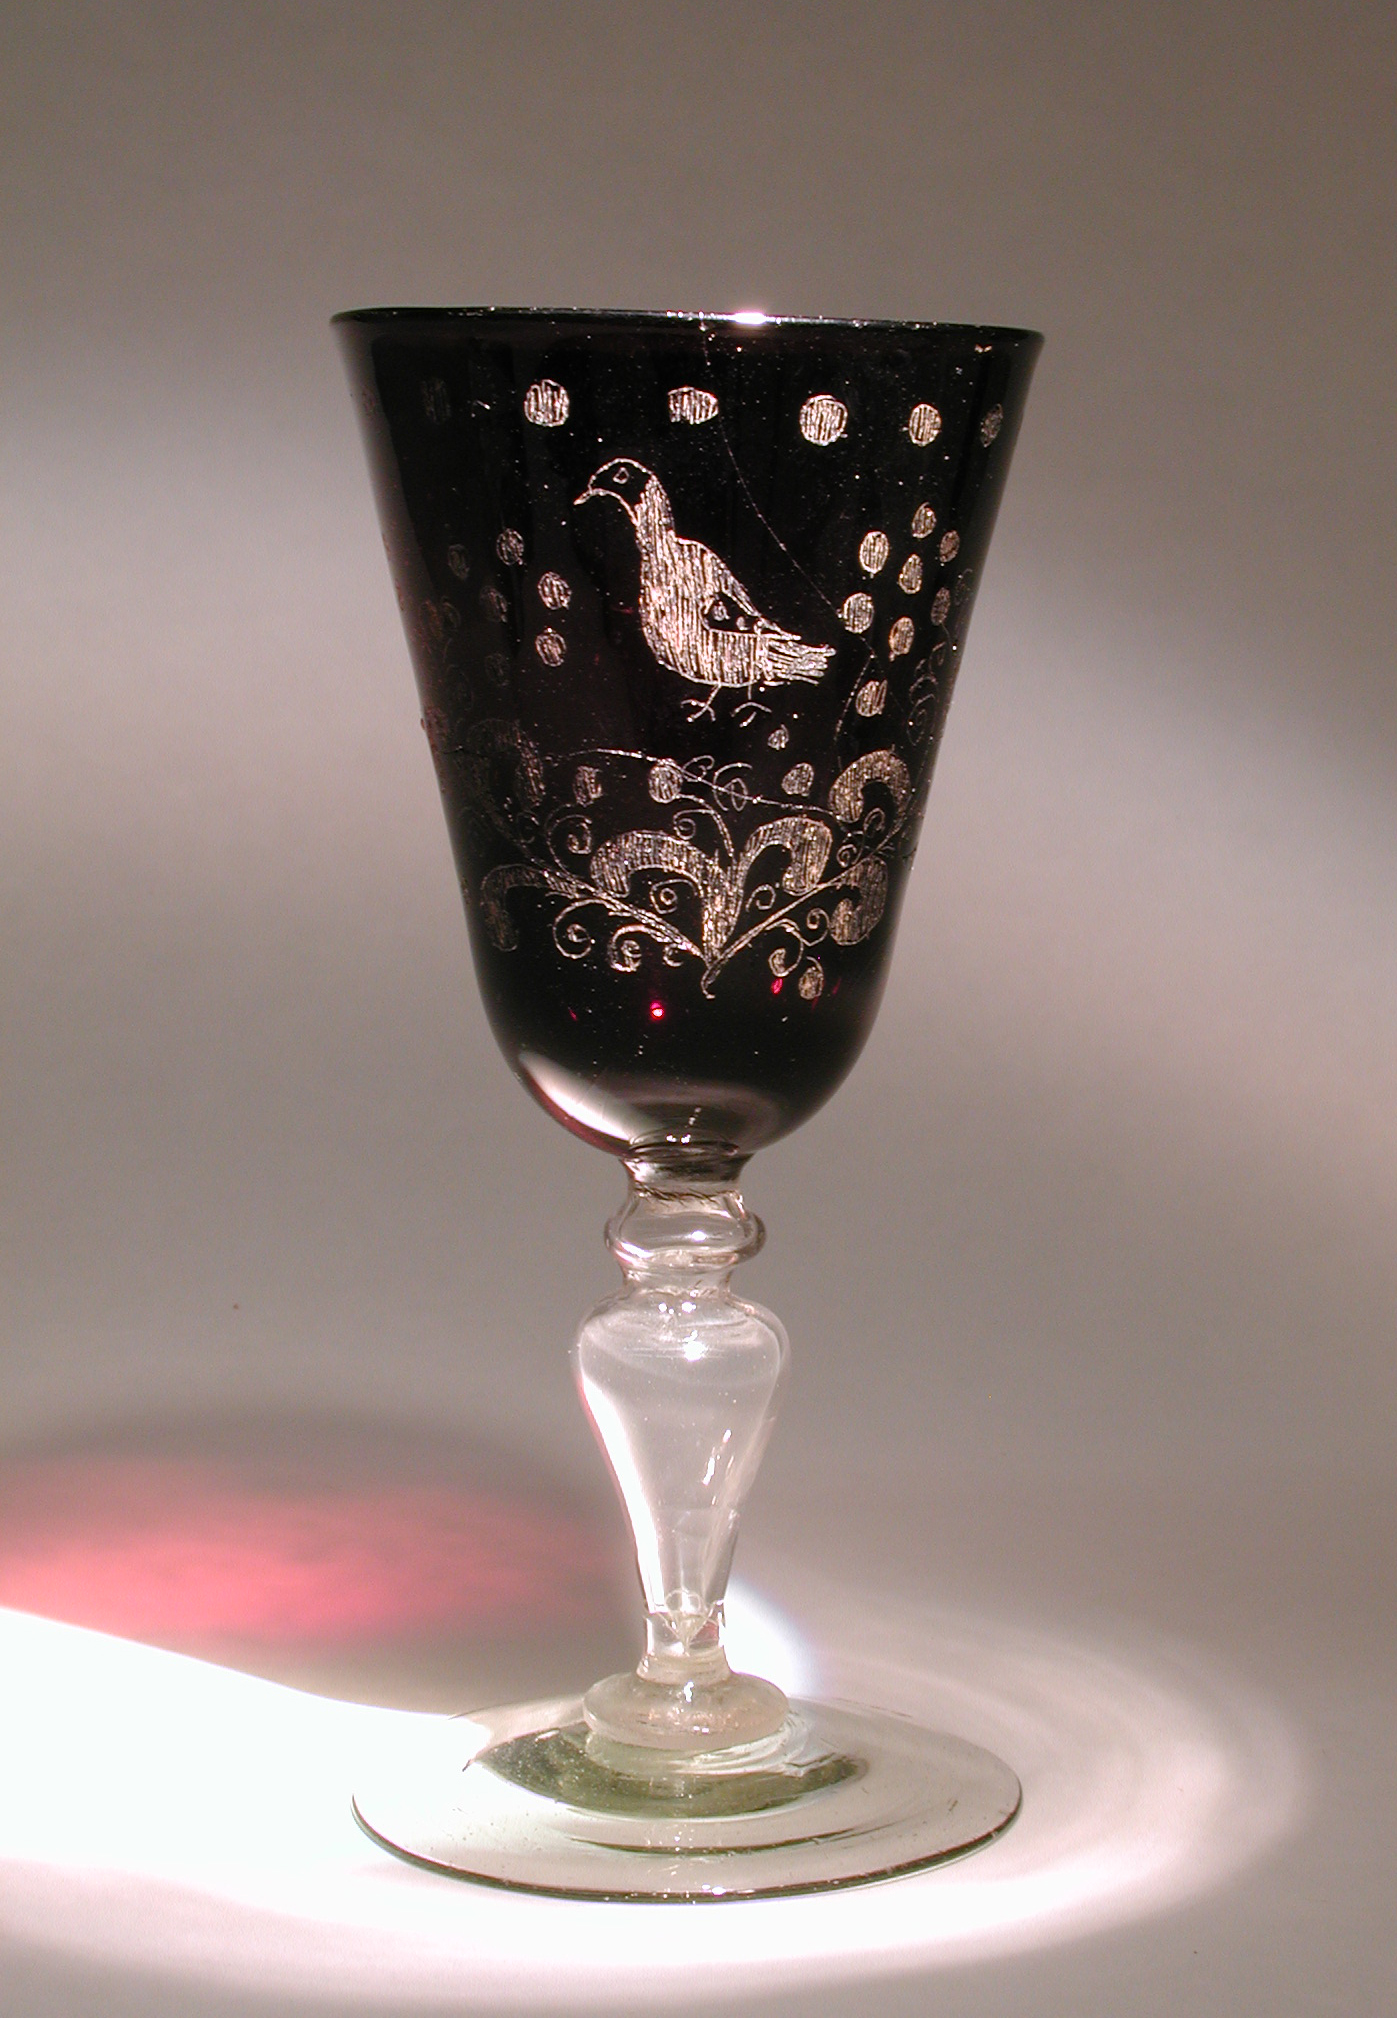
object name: goblet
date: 1601-1700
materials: glass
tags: birds